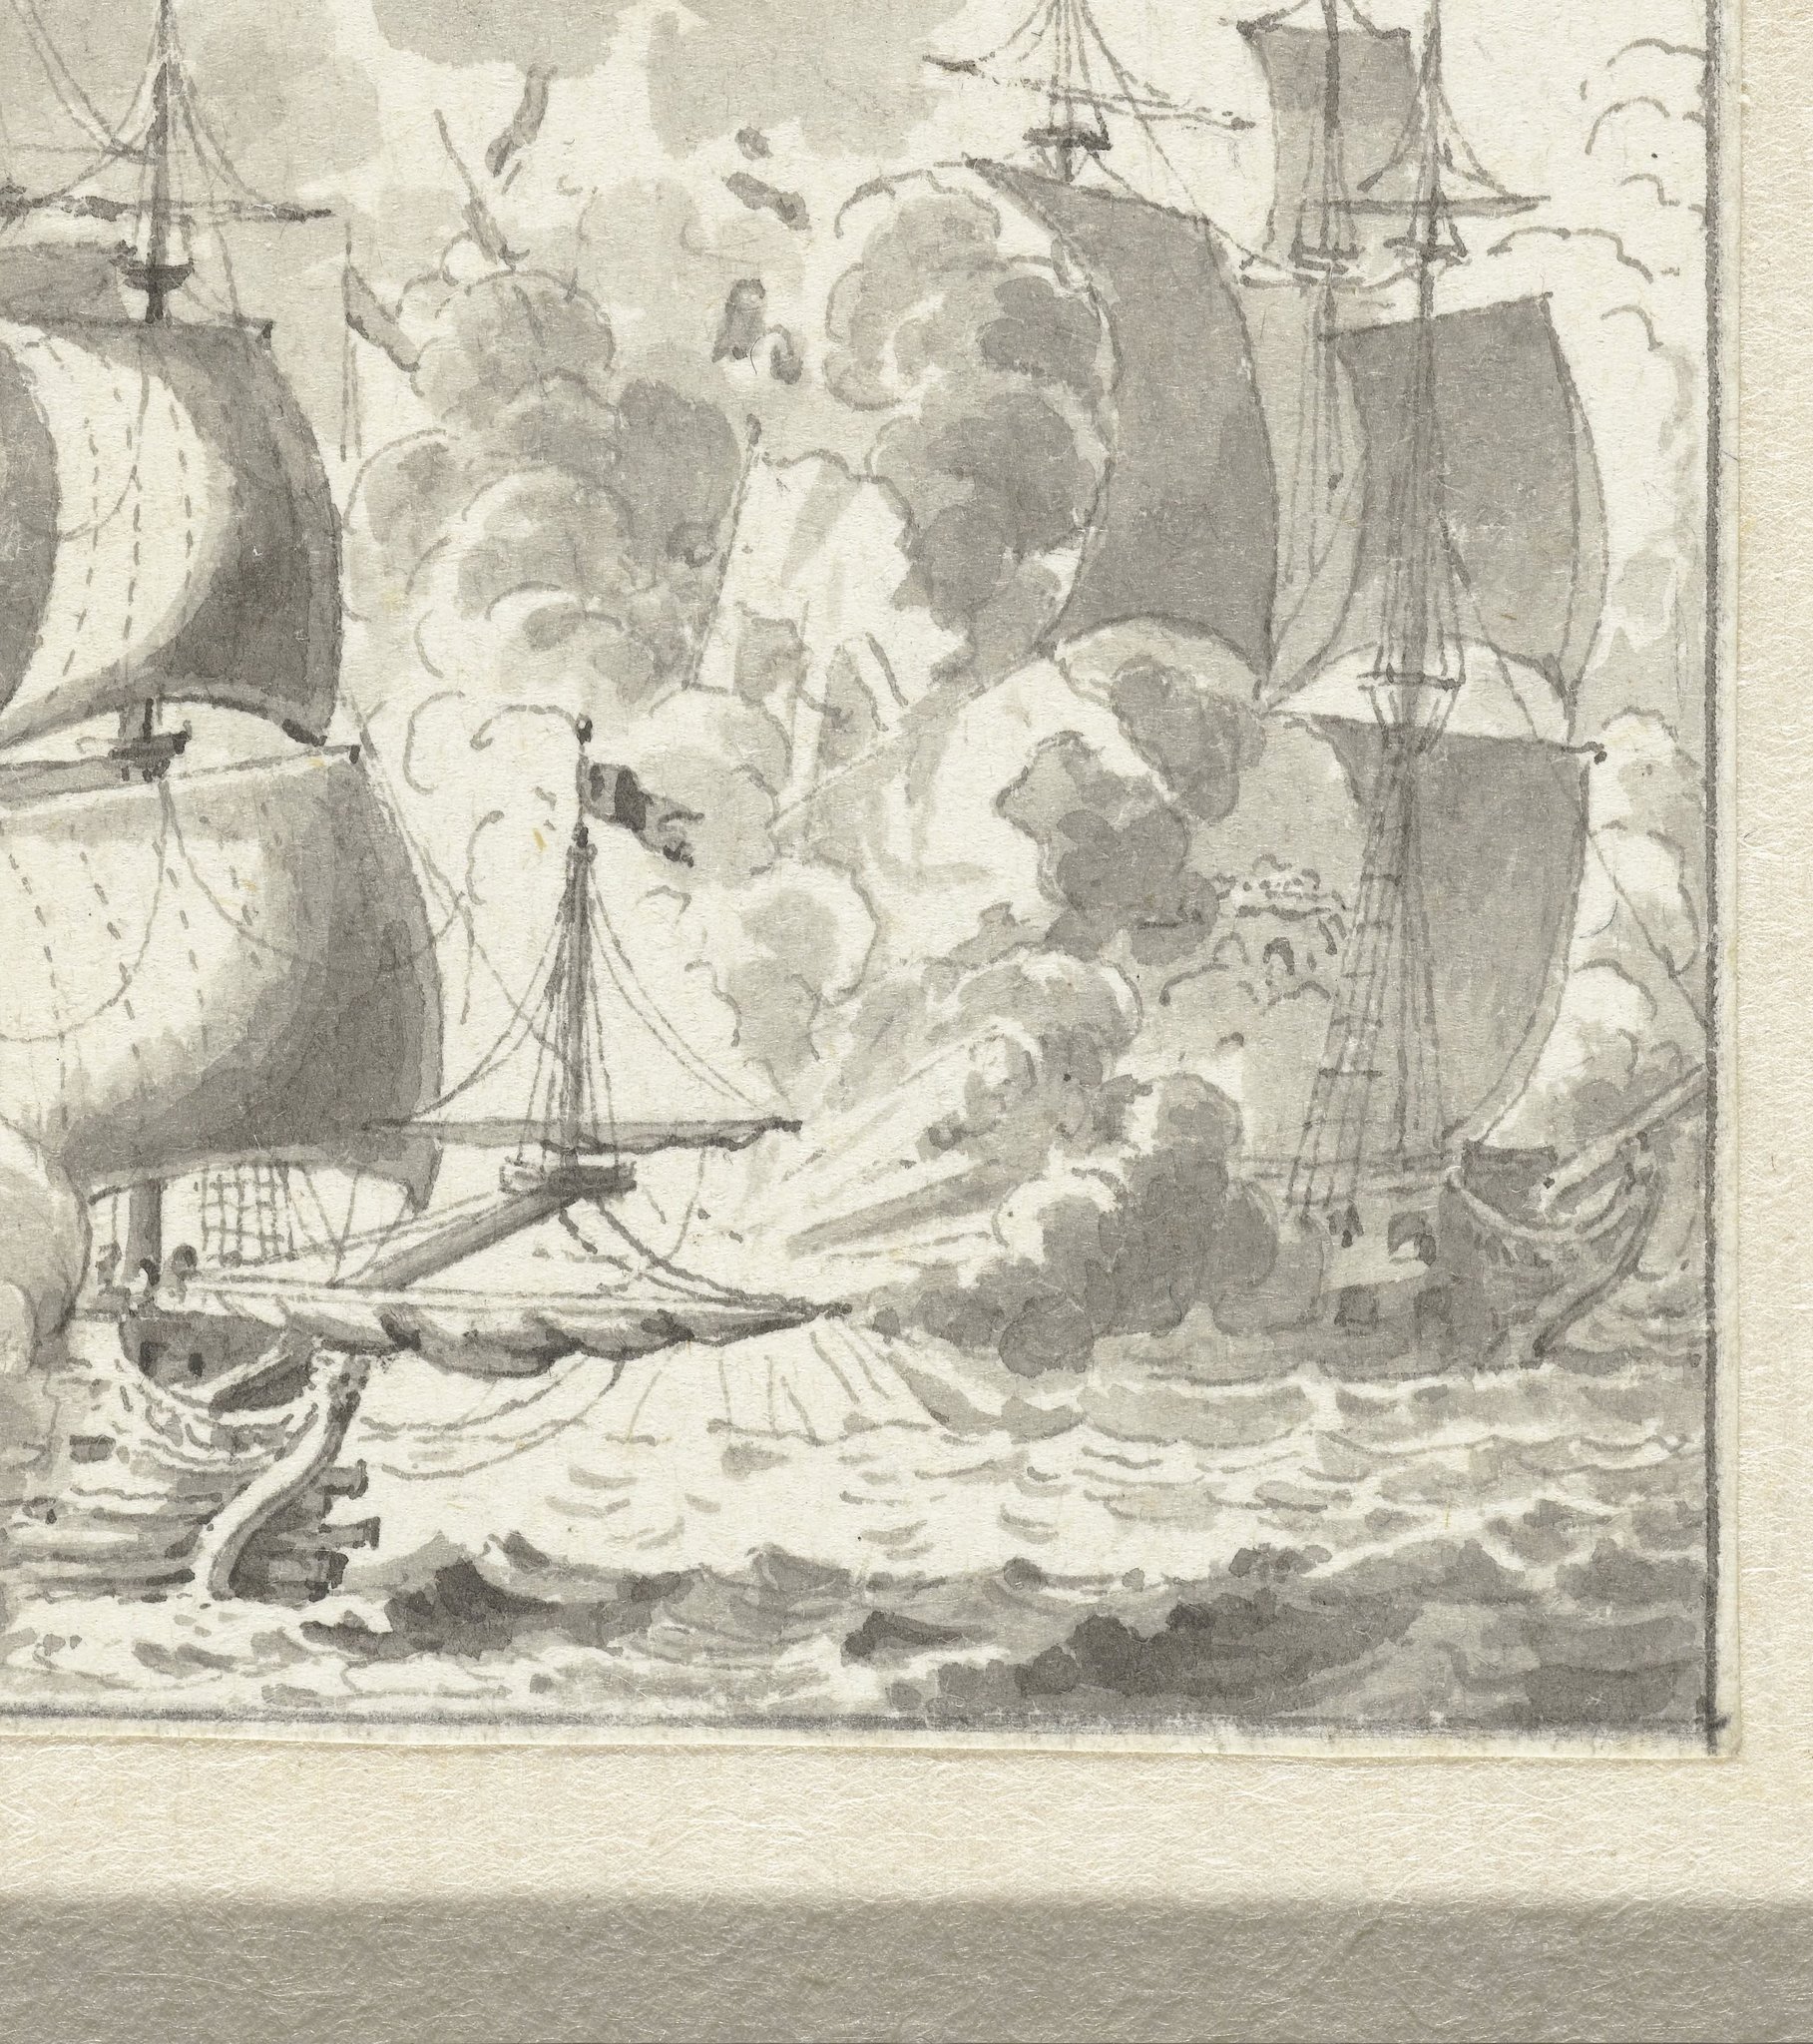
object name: design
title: In 't Jaar 1666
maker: Anonymous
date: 1789-1810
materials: ink, paper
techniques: brush, pen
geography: netherlands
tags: battle (+ naval force)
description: Een zeeslag, waarschijnlijk de Vierdaagse Zeeslag, 11-14 juni 1666.